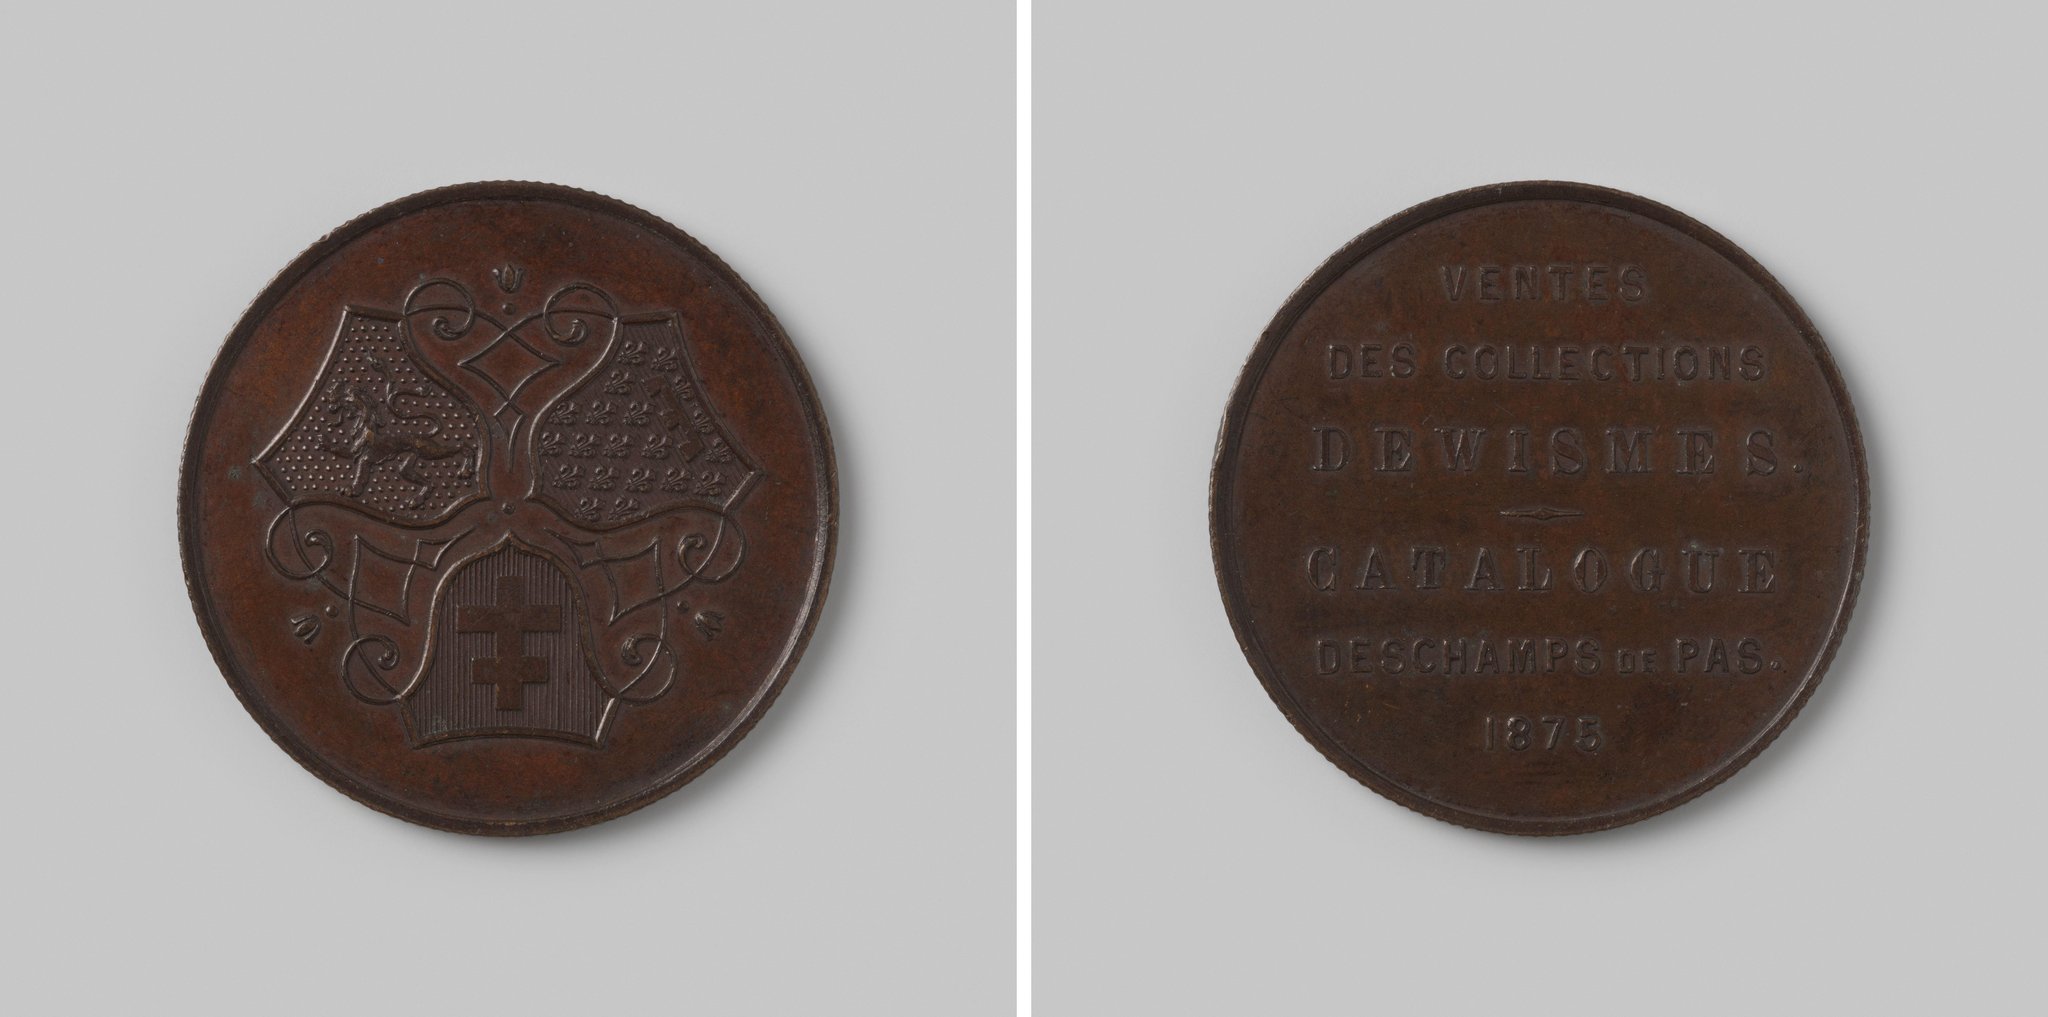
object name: history medal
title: Verkoop van de collectie Dewismes, gecatalogiseerd door Deschamps de Pas, 1875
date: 1875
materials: bronze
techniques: striking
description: Bronzen penning, op de voorzijde drie wapenschilden op een lijnenpatroon, op de keerzijde zes regels tekst.